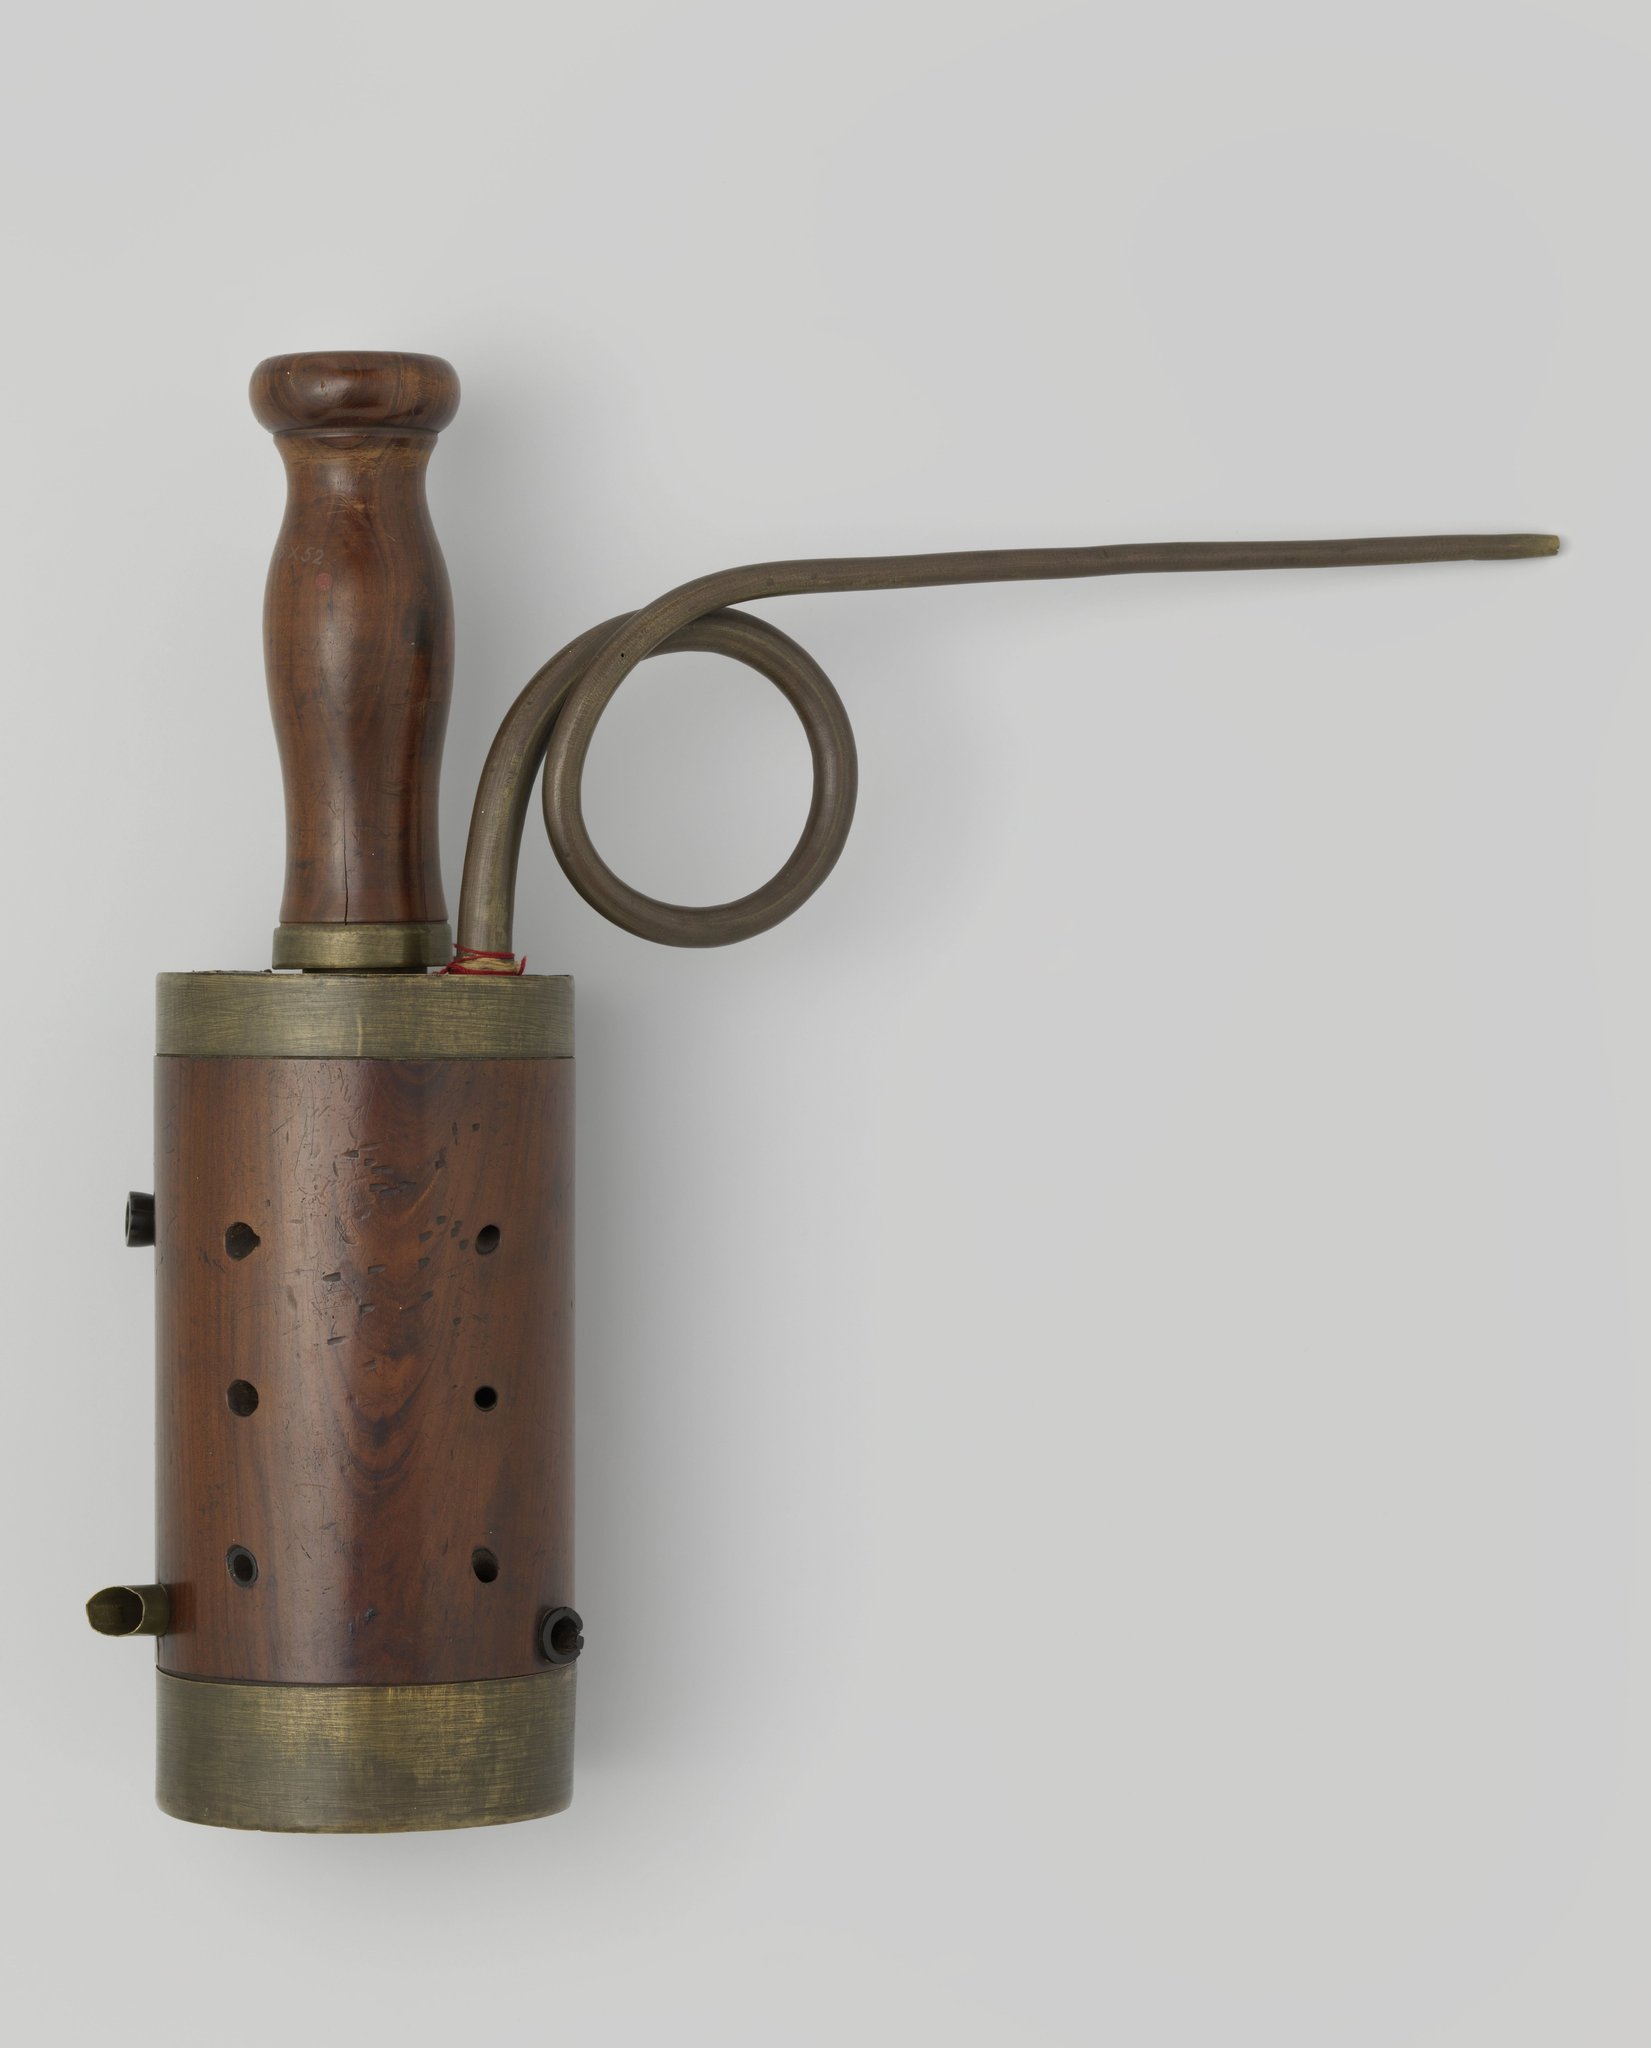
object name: musical instrument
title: Ranket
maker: Anonymous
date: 1780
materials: brass, cork, wood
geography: netherlands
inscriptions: inscription, at the side of the corpus: ‘PYP 4 MAAL’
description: The ranket, or racket, was already known at the beginning of the 16th century. This is a bassoon in which the single wind channel is so contorted that it fits into this compact shape. The finger holes are visible on the exterior of the instrument.